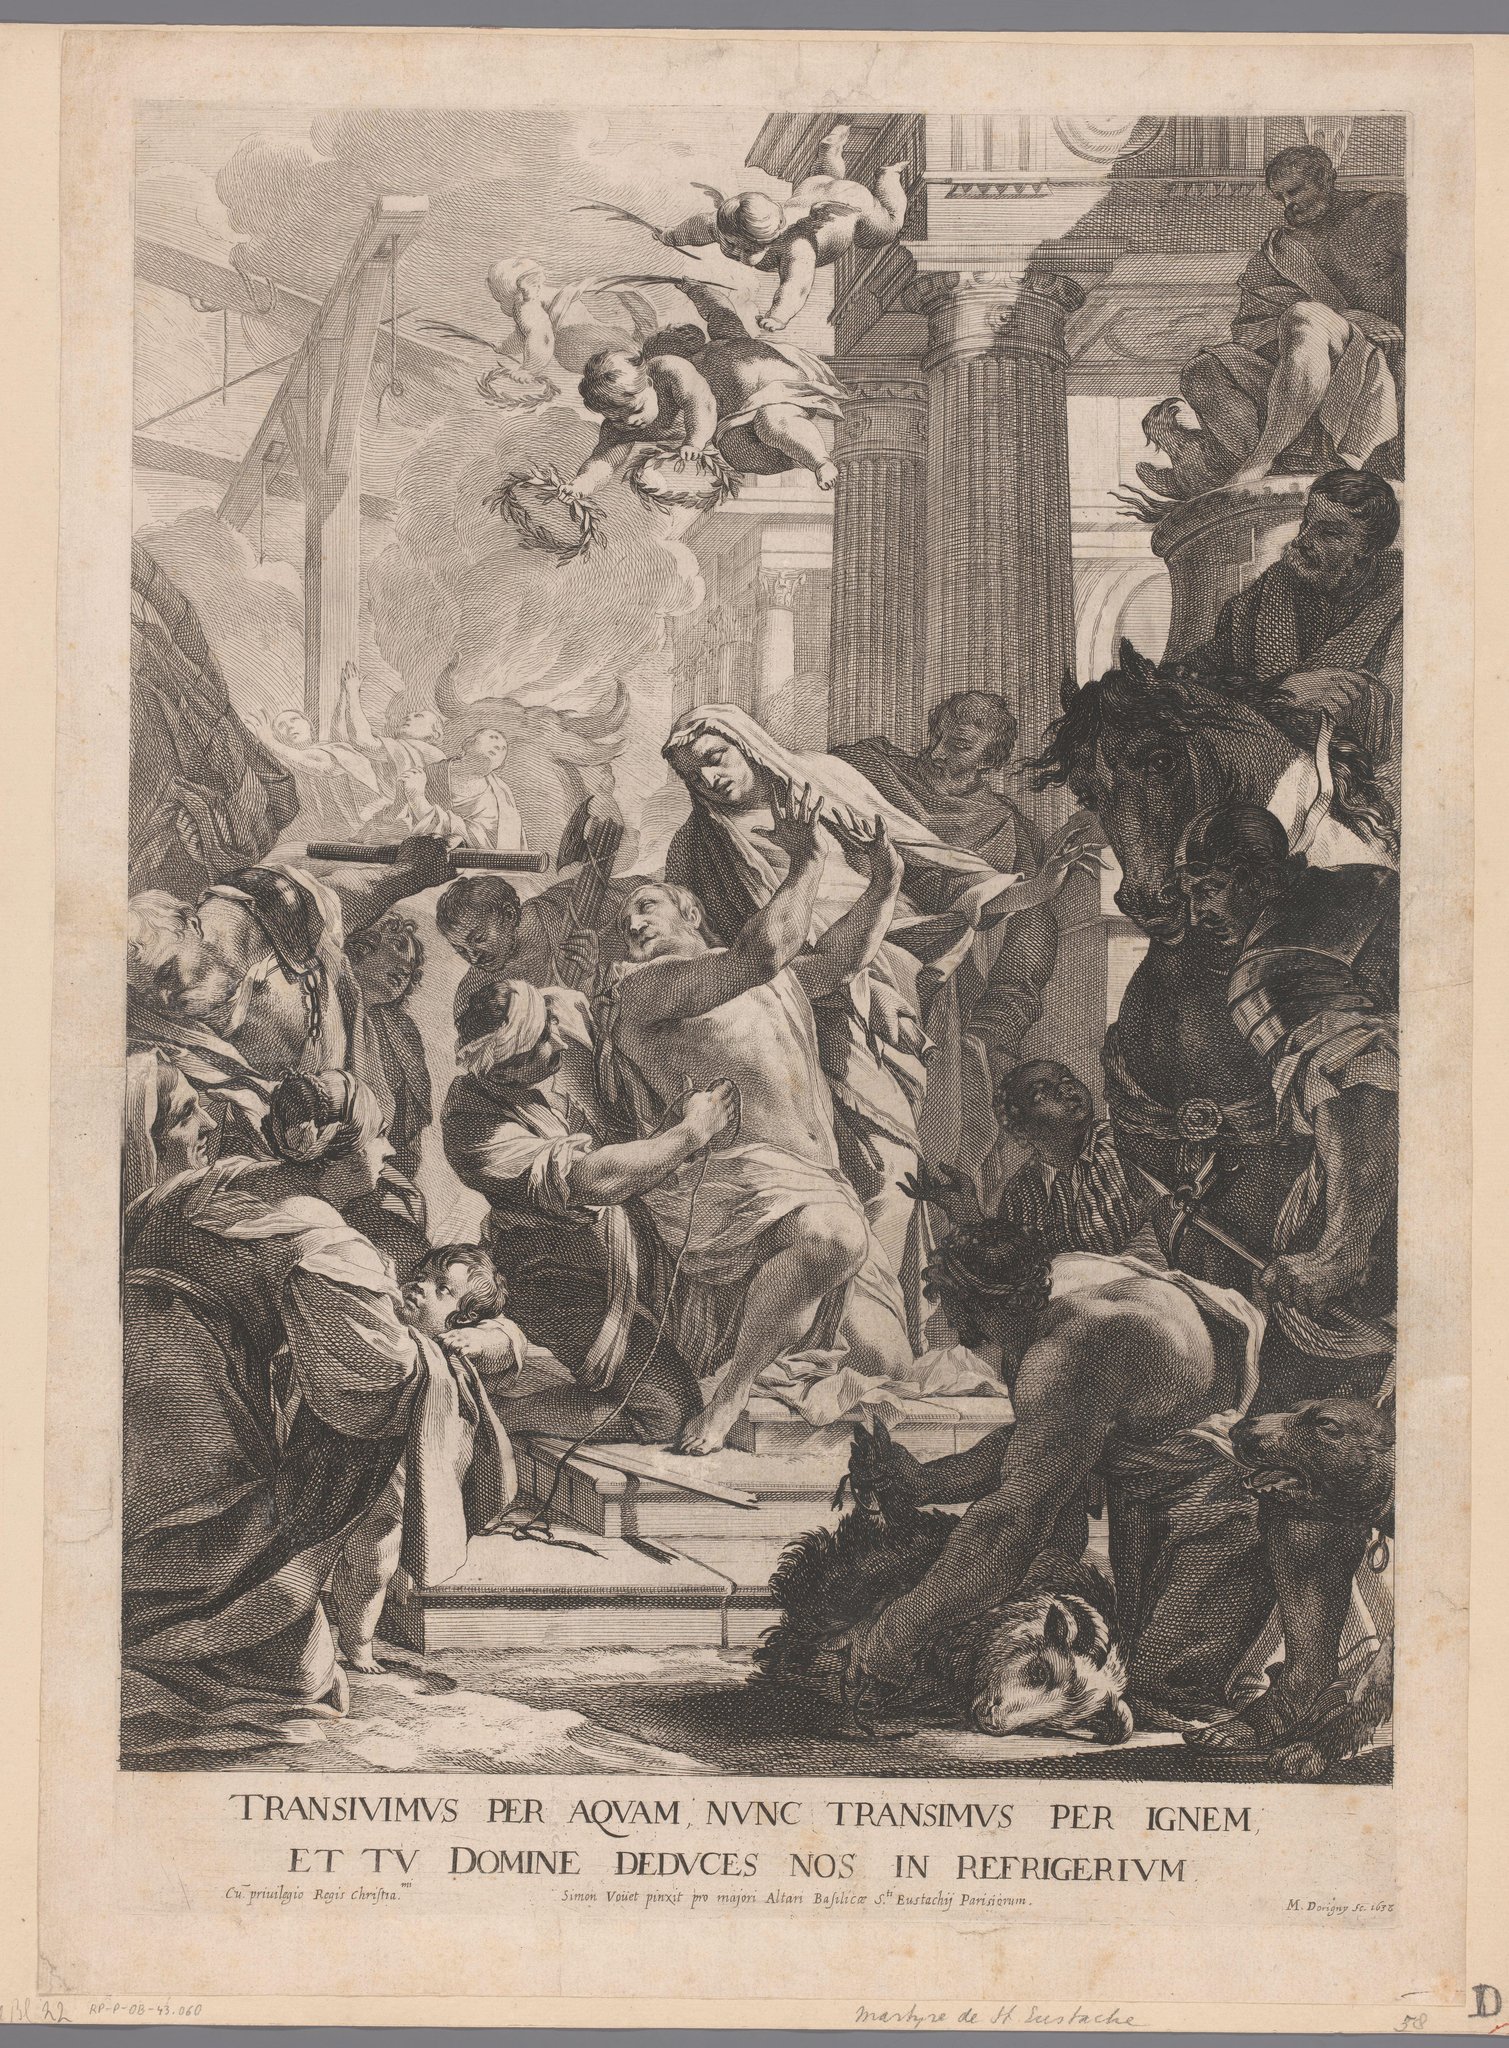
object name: print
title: Martelaarschap van Eustachius van Rome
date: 1638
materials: paper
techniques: engraving, etching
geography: france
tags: martyrdom, suffering, misfortune, death of st. eustace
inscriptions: collector's mark: Lugt 240